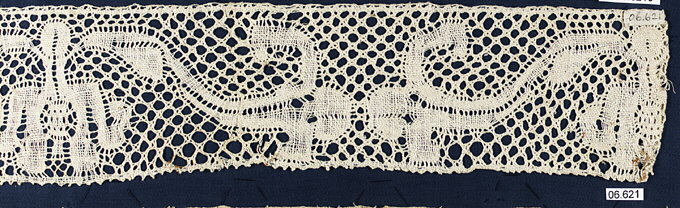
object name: fragment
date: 1701-1800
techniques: lace